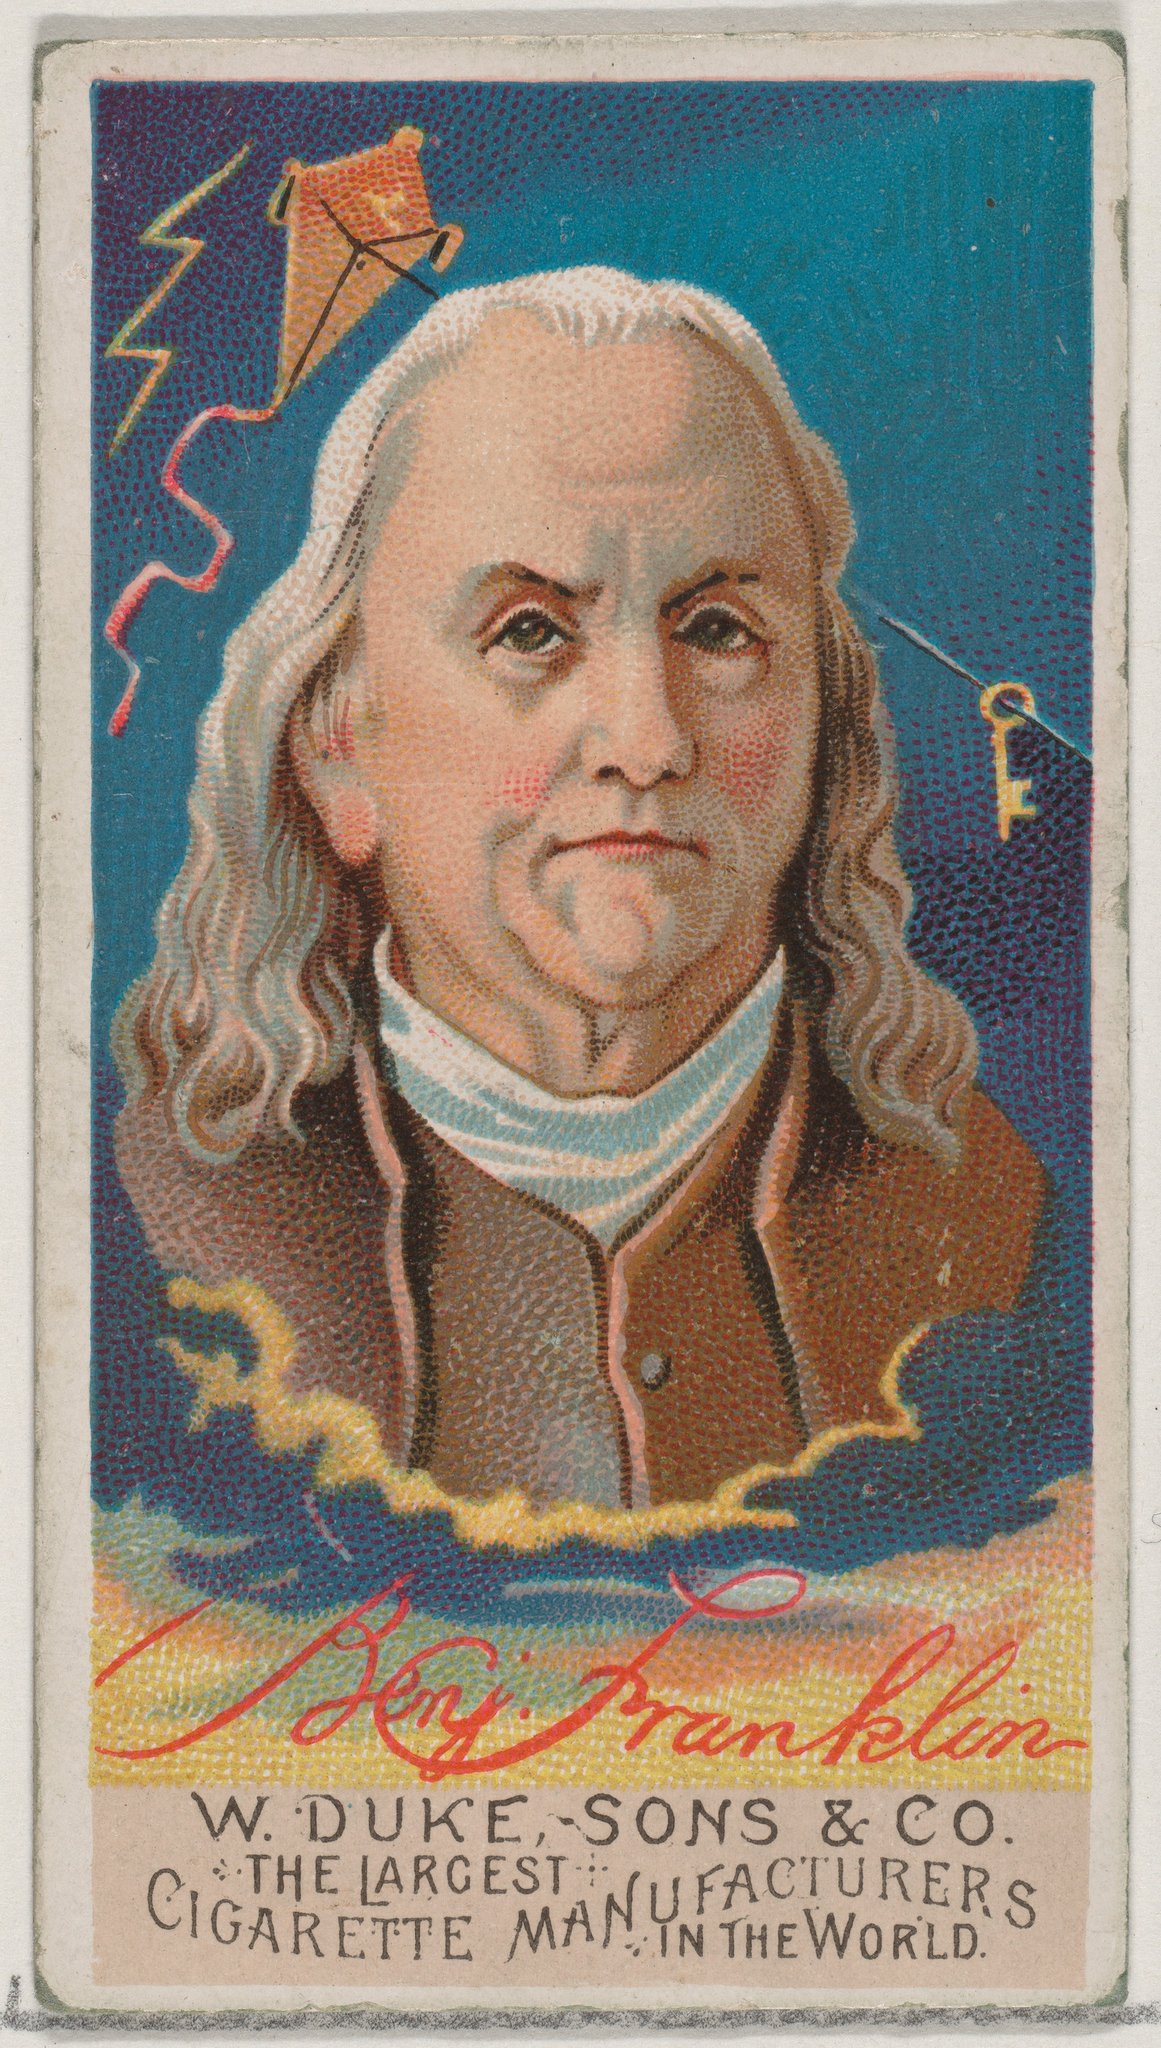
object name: print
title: Benjamin Franklin, from the series Great Americans (N76) for Duke brand cigarettes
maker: w. duke, sons & co.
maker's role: publisher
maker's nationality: american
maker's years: 1870-1920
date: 1888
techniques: color lithograph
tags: men